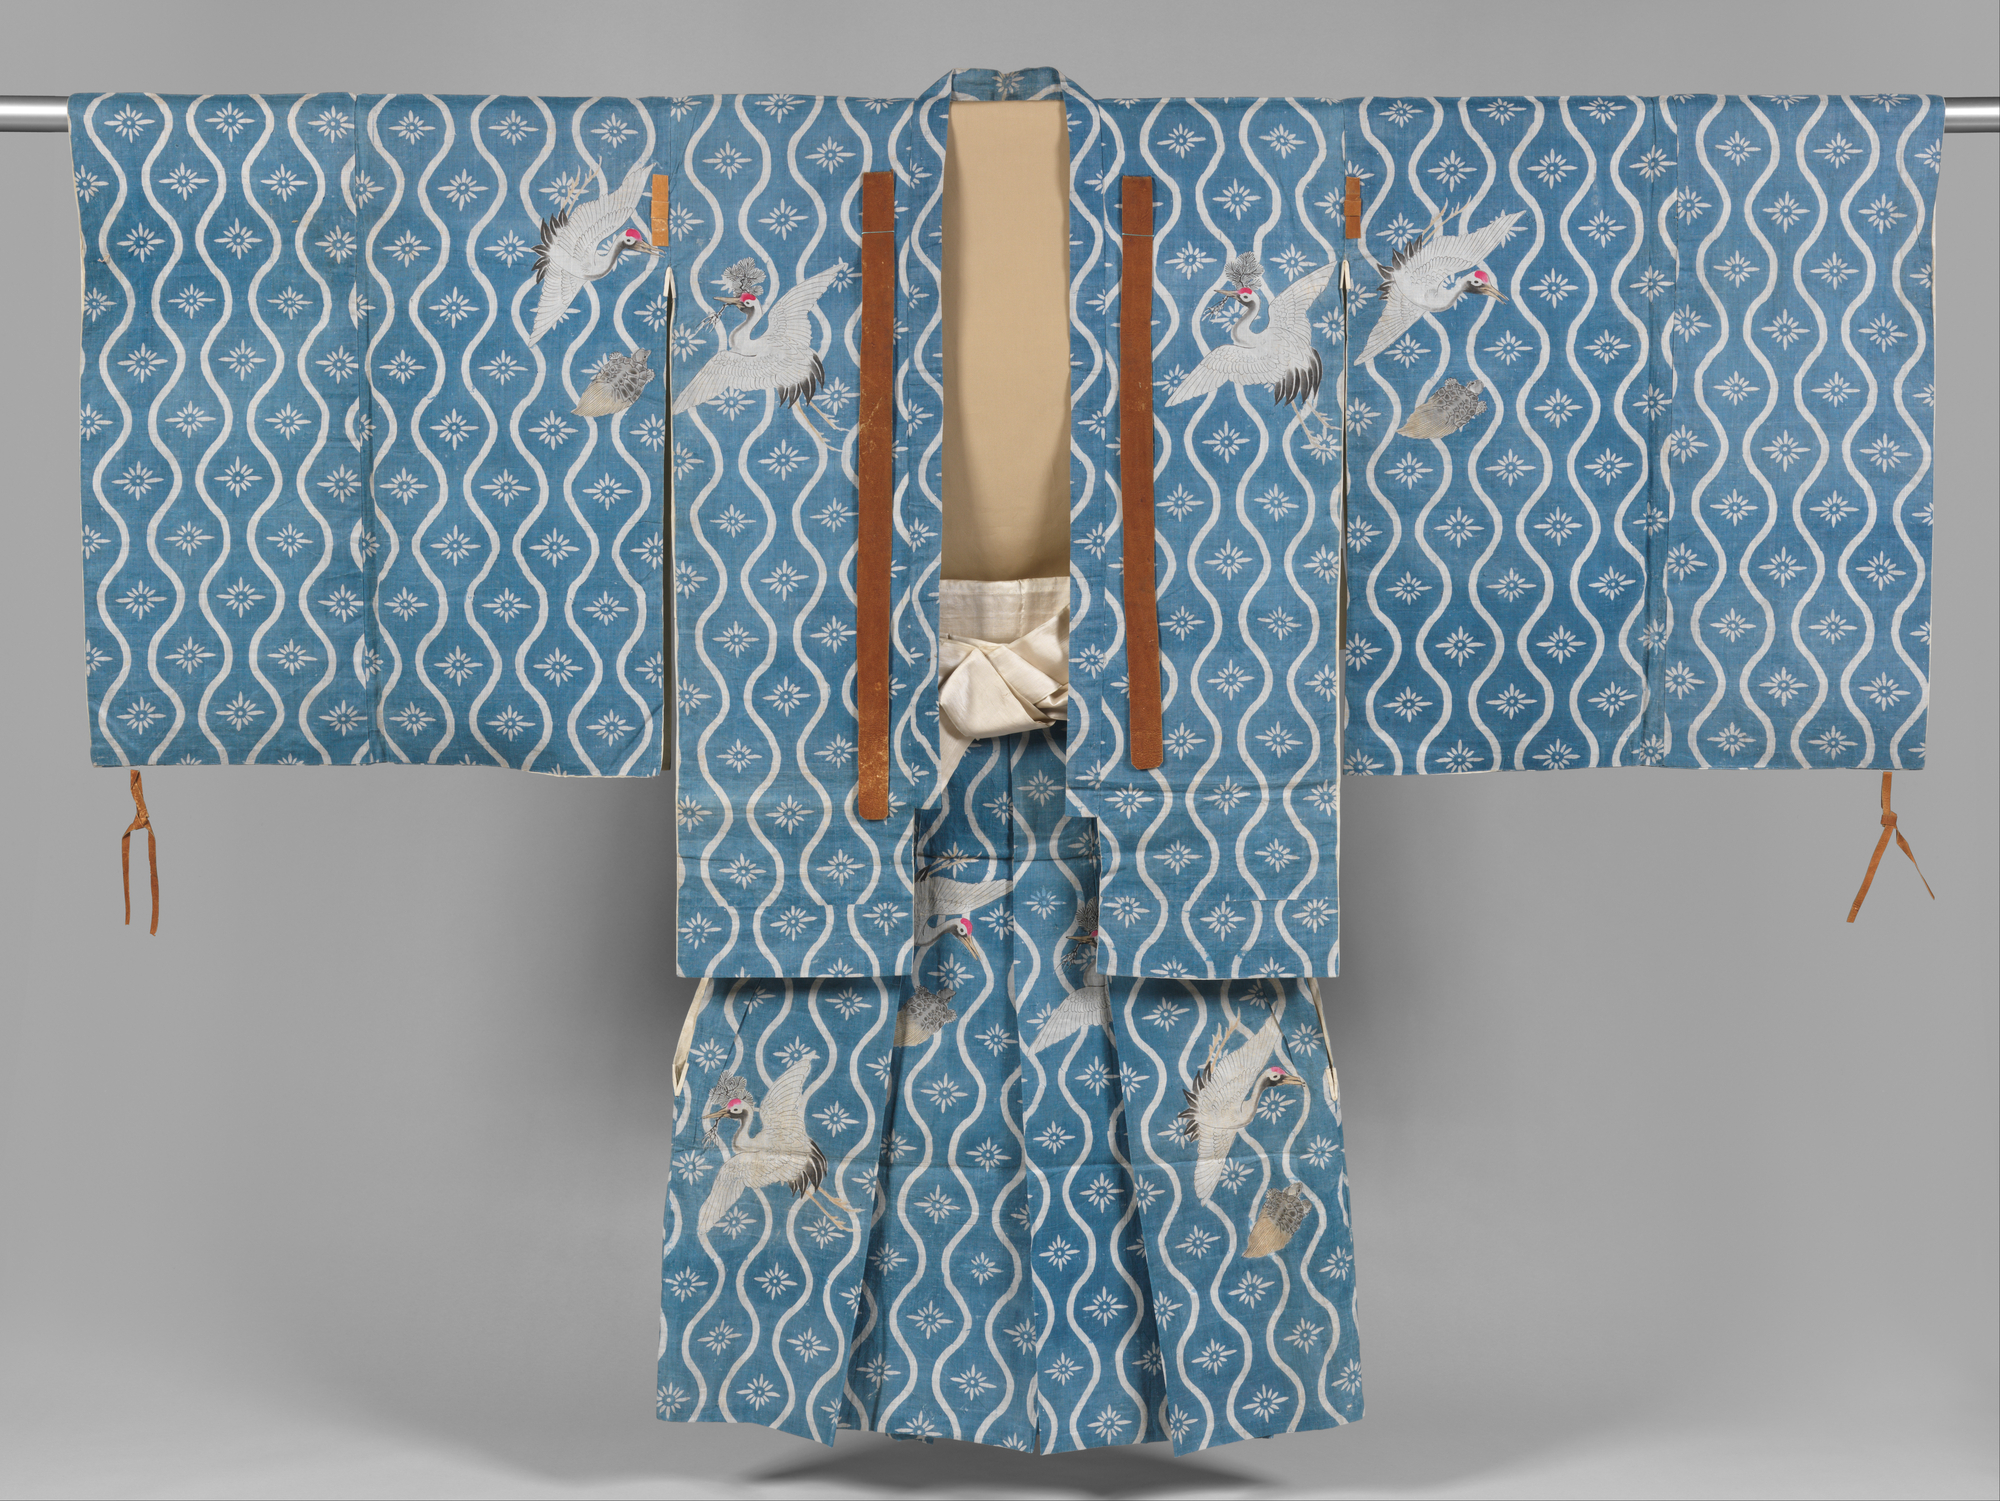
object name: noh costume hitatare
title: Noh costume (Hitatare)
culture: japanese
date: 1801-1900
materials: fiber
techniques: dyeing, painting, weave, resist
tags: cranes